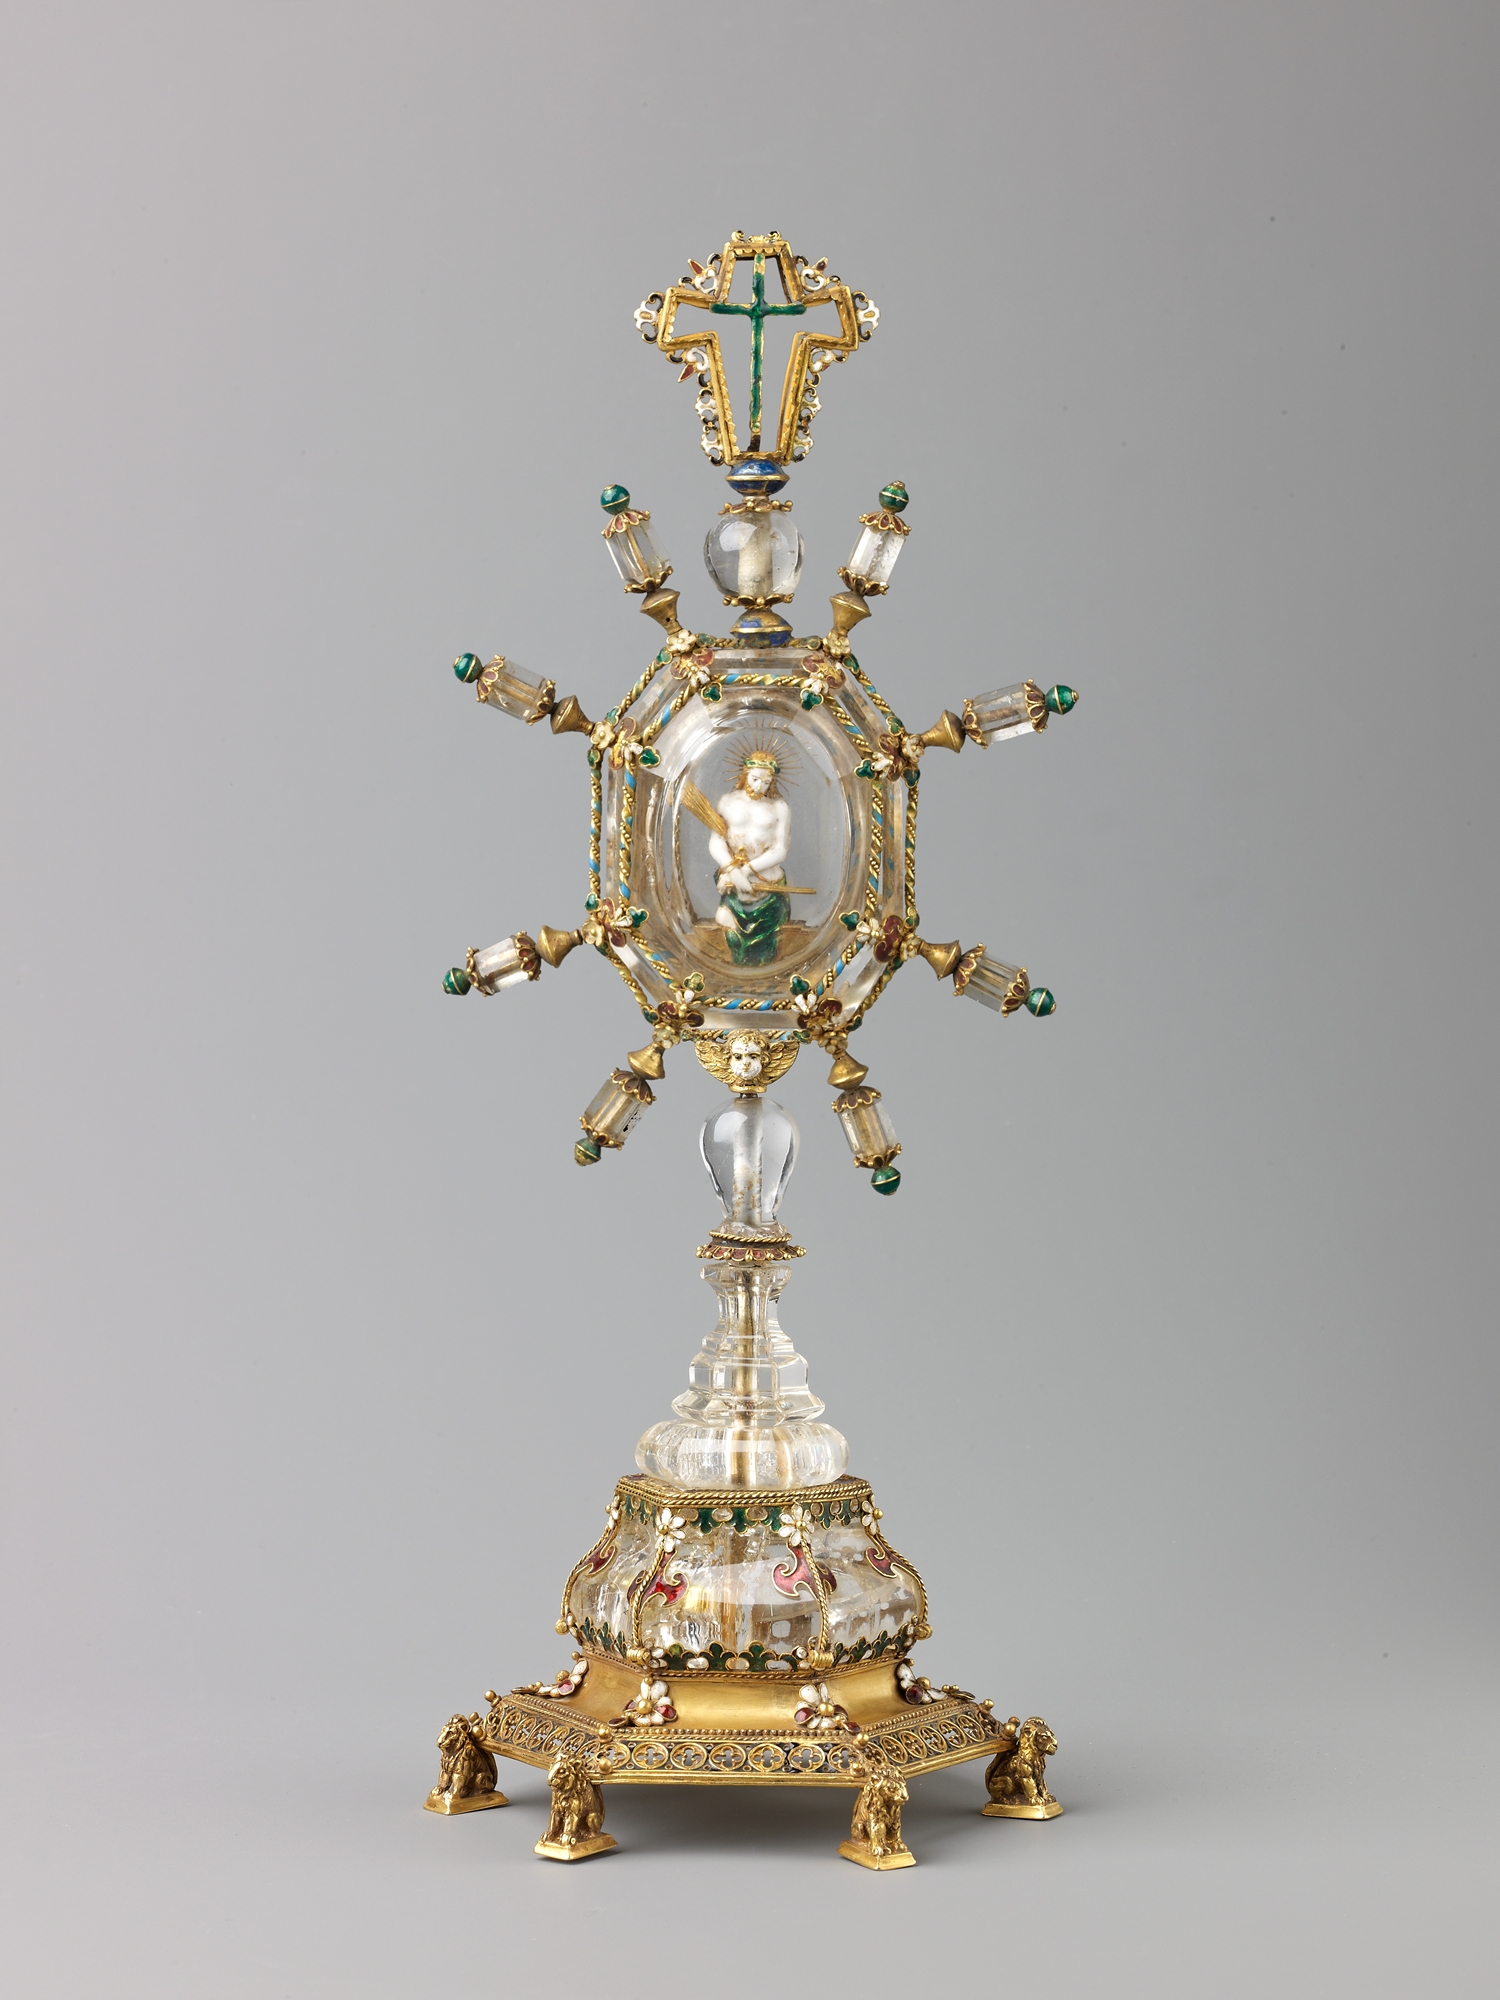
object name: ostensorium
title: Reliquary(?)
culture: spanish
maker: spanish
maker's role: artist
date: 1867-1900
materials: enamel, gold, quartz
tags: christ